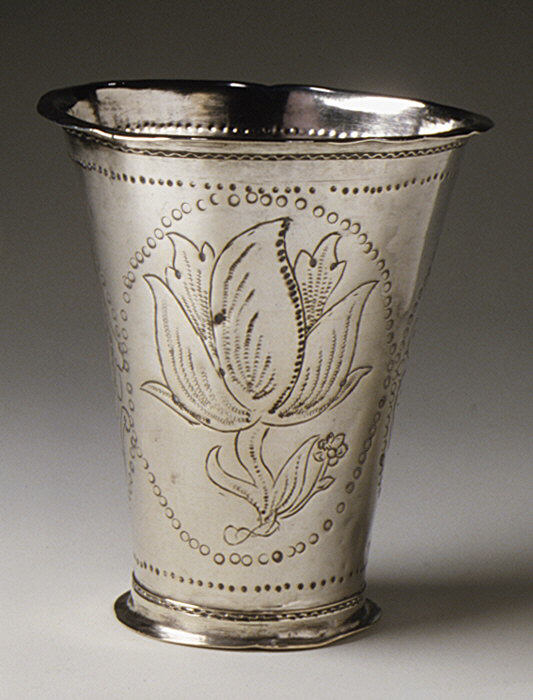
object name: beaker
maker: johan mansson wennerwall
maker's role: maker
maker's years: 1703-1768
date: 1741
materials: gilt, silver